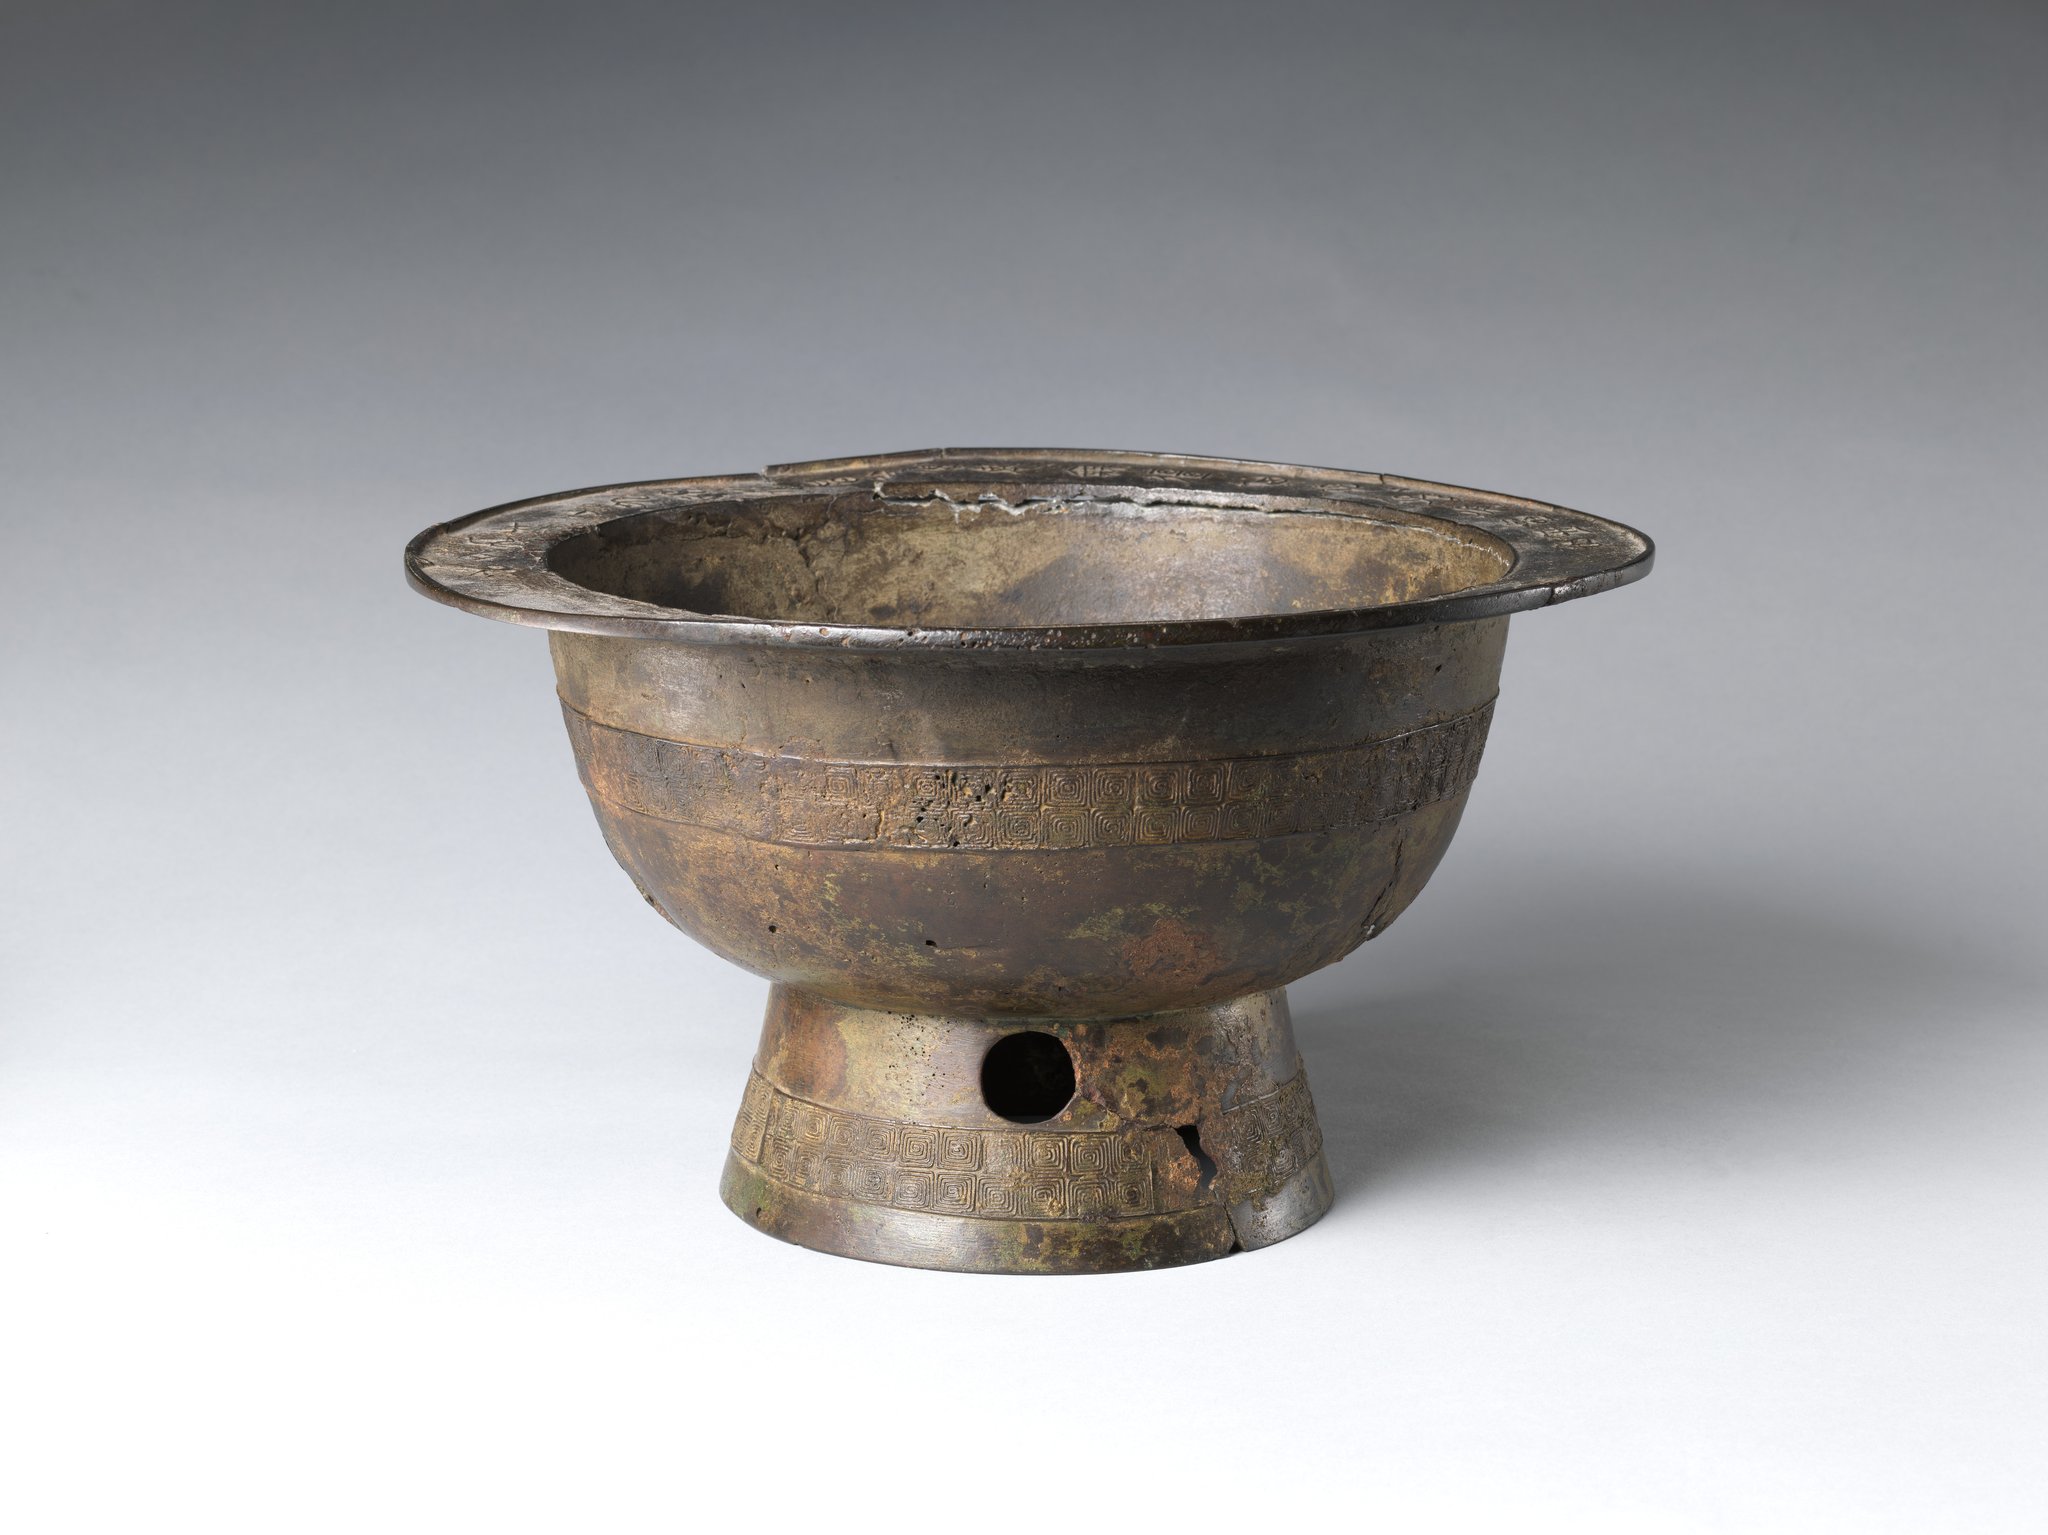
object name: basin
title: Basin with turtles and fish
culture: chinese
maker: unidentified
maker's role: artist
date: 1301-1400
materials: bronze